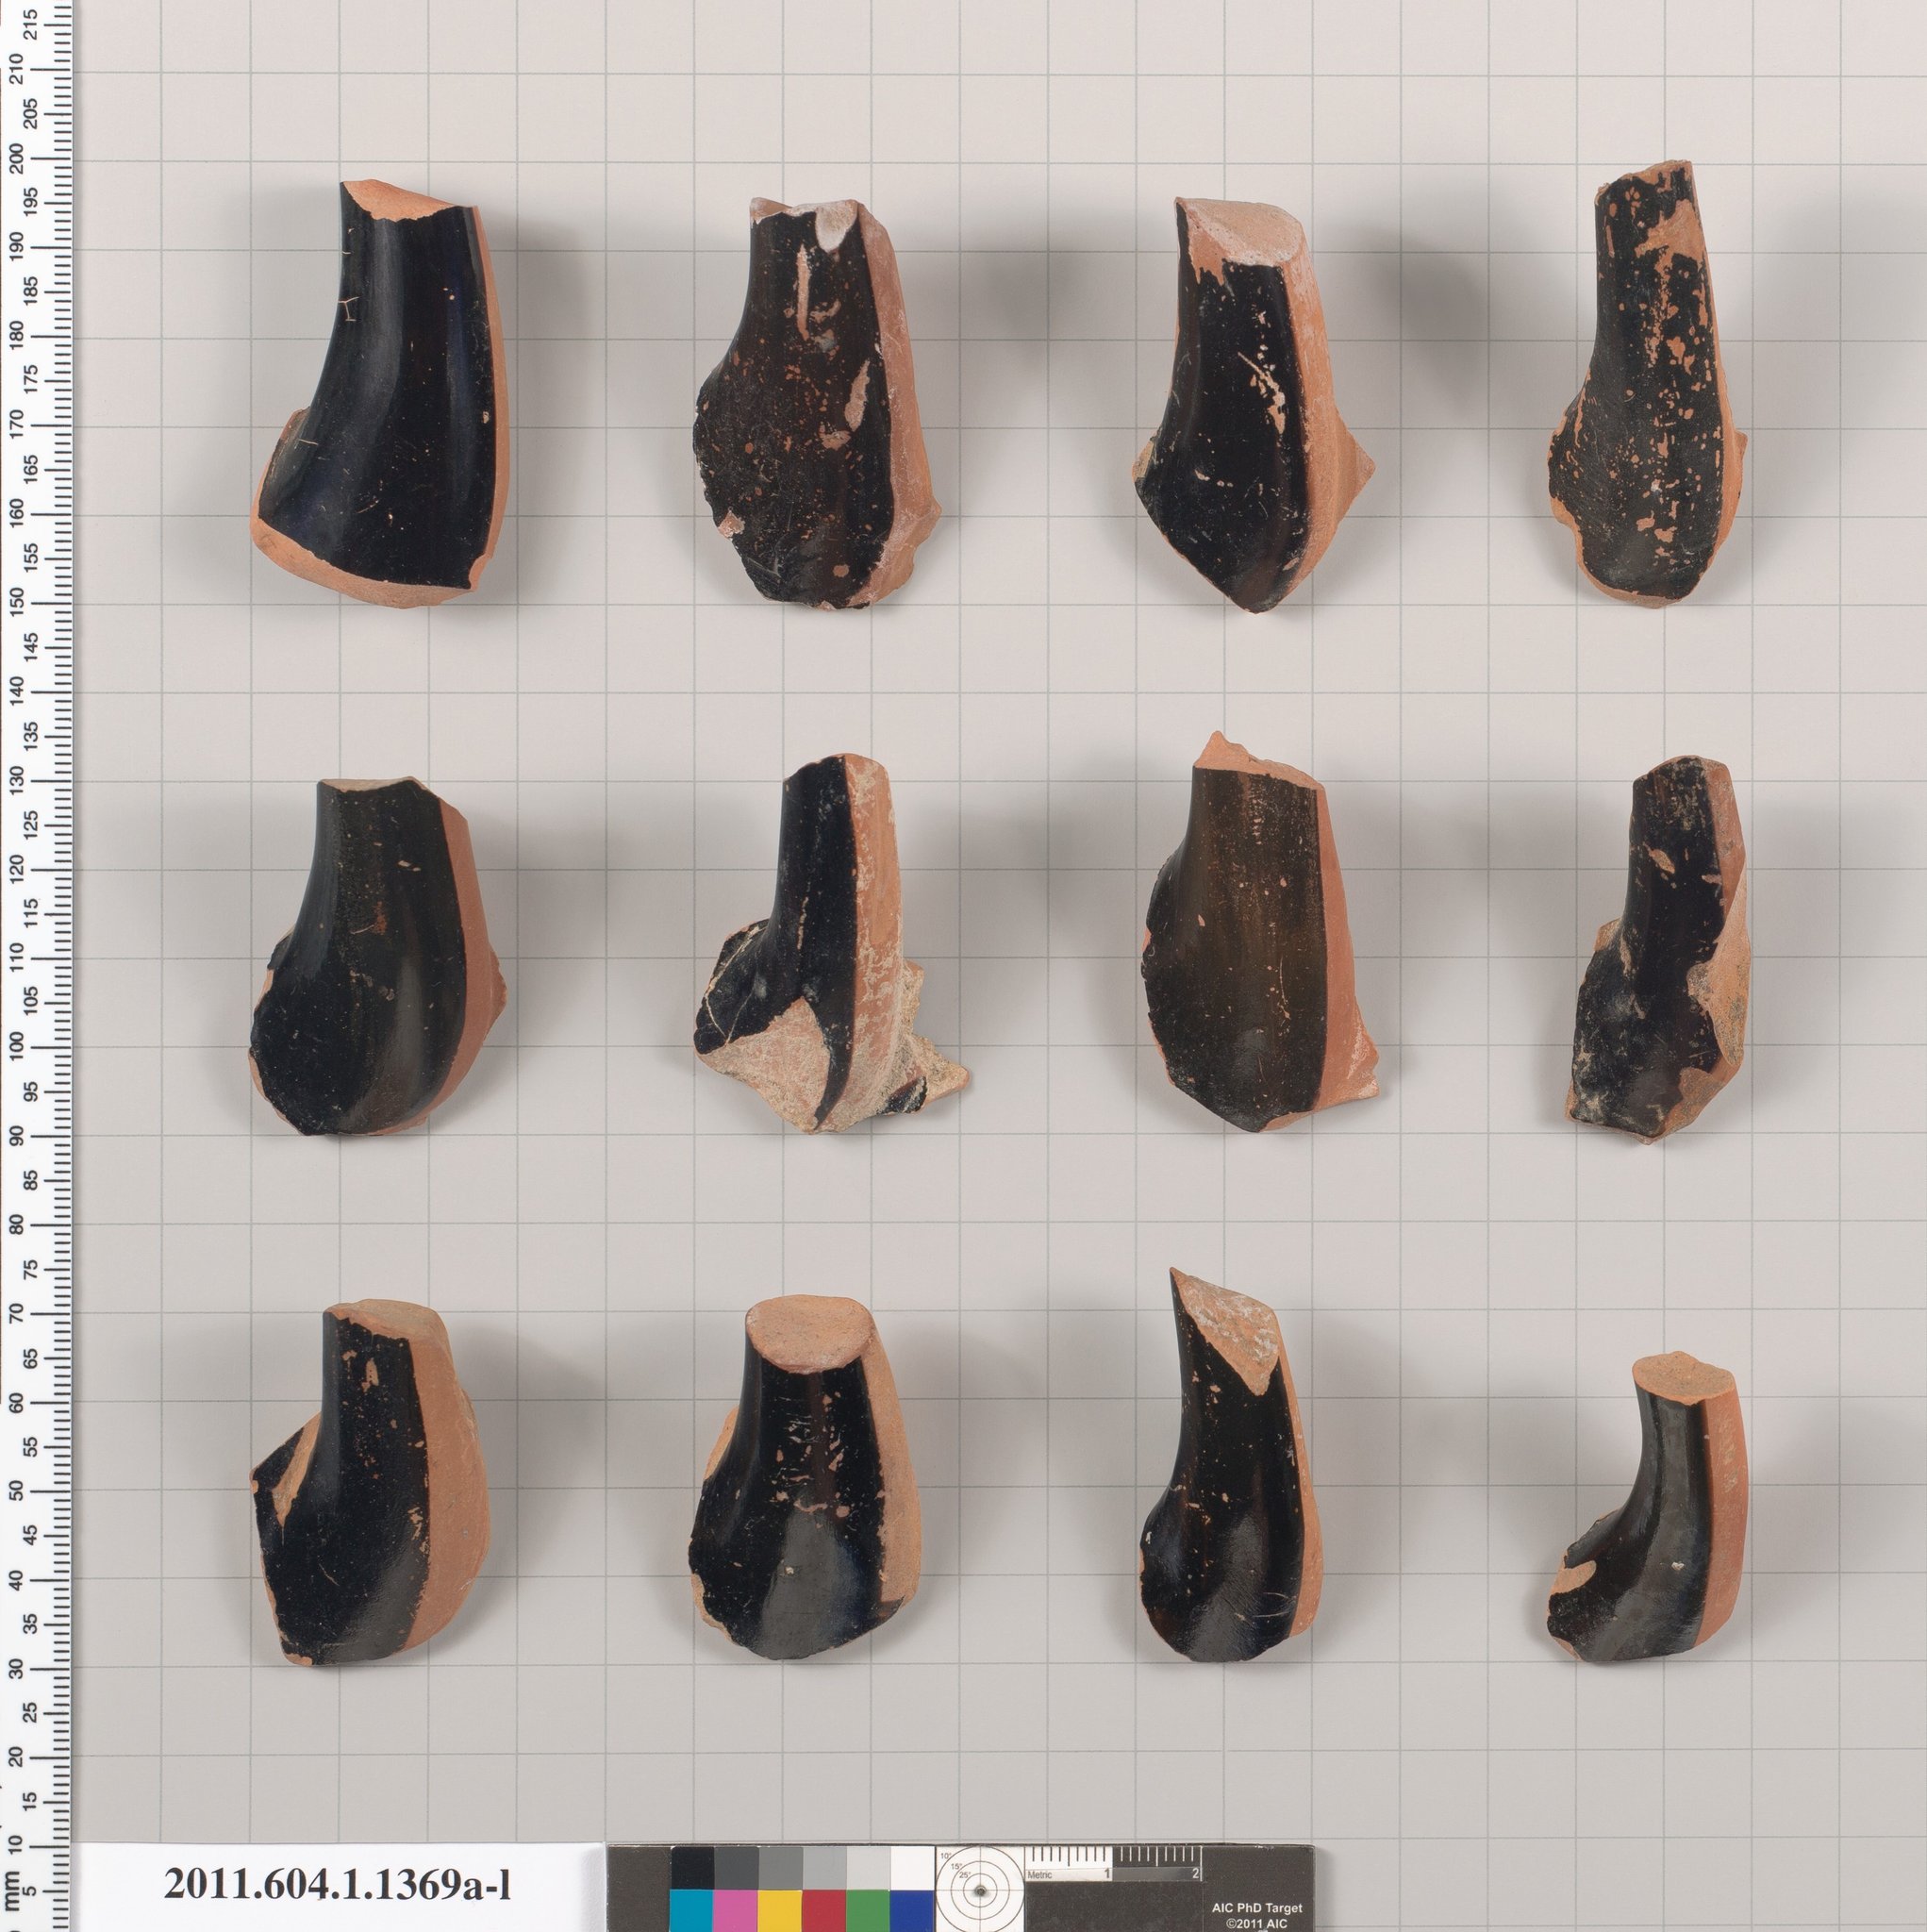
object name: kylix fragment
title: Terracotta fragments of kylikes (drinking cups)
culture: greek, attic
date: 500-401 BCE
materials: terracotta